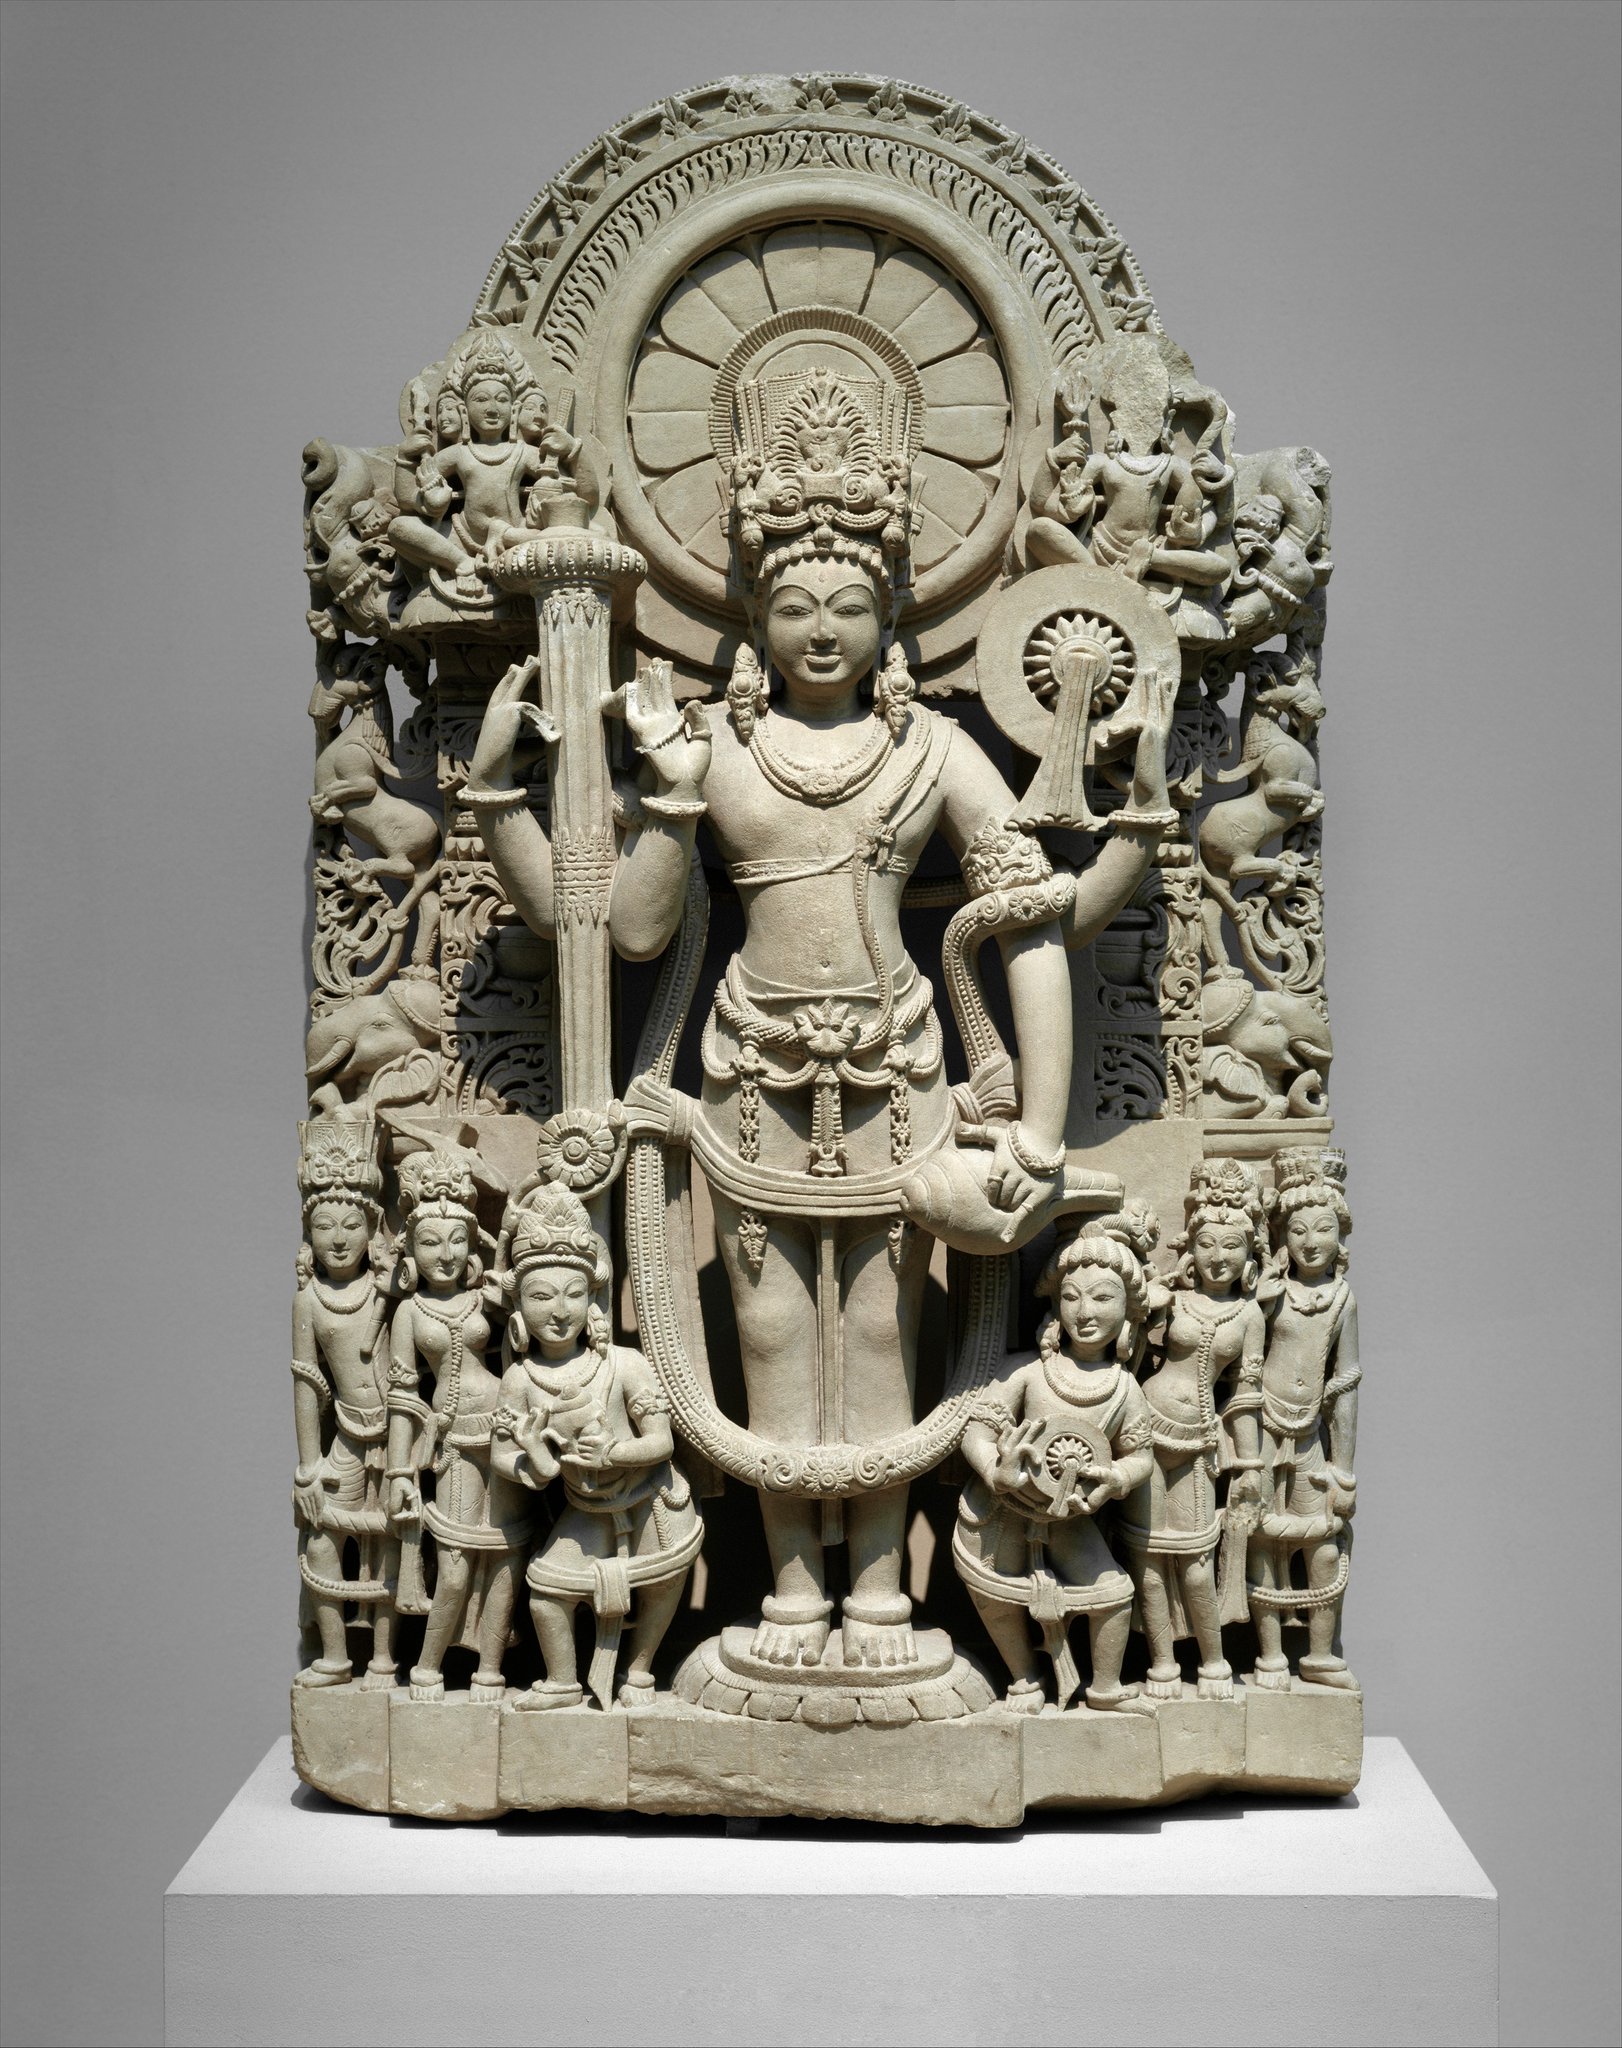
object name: stele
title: Vishnu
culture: indian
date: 901-1100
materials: stone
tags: elephants,brahma,shiva,vishnu